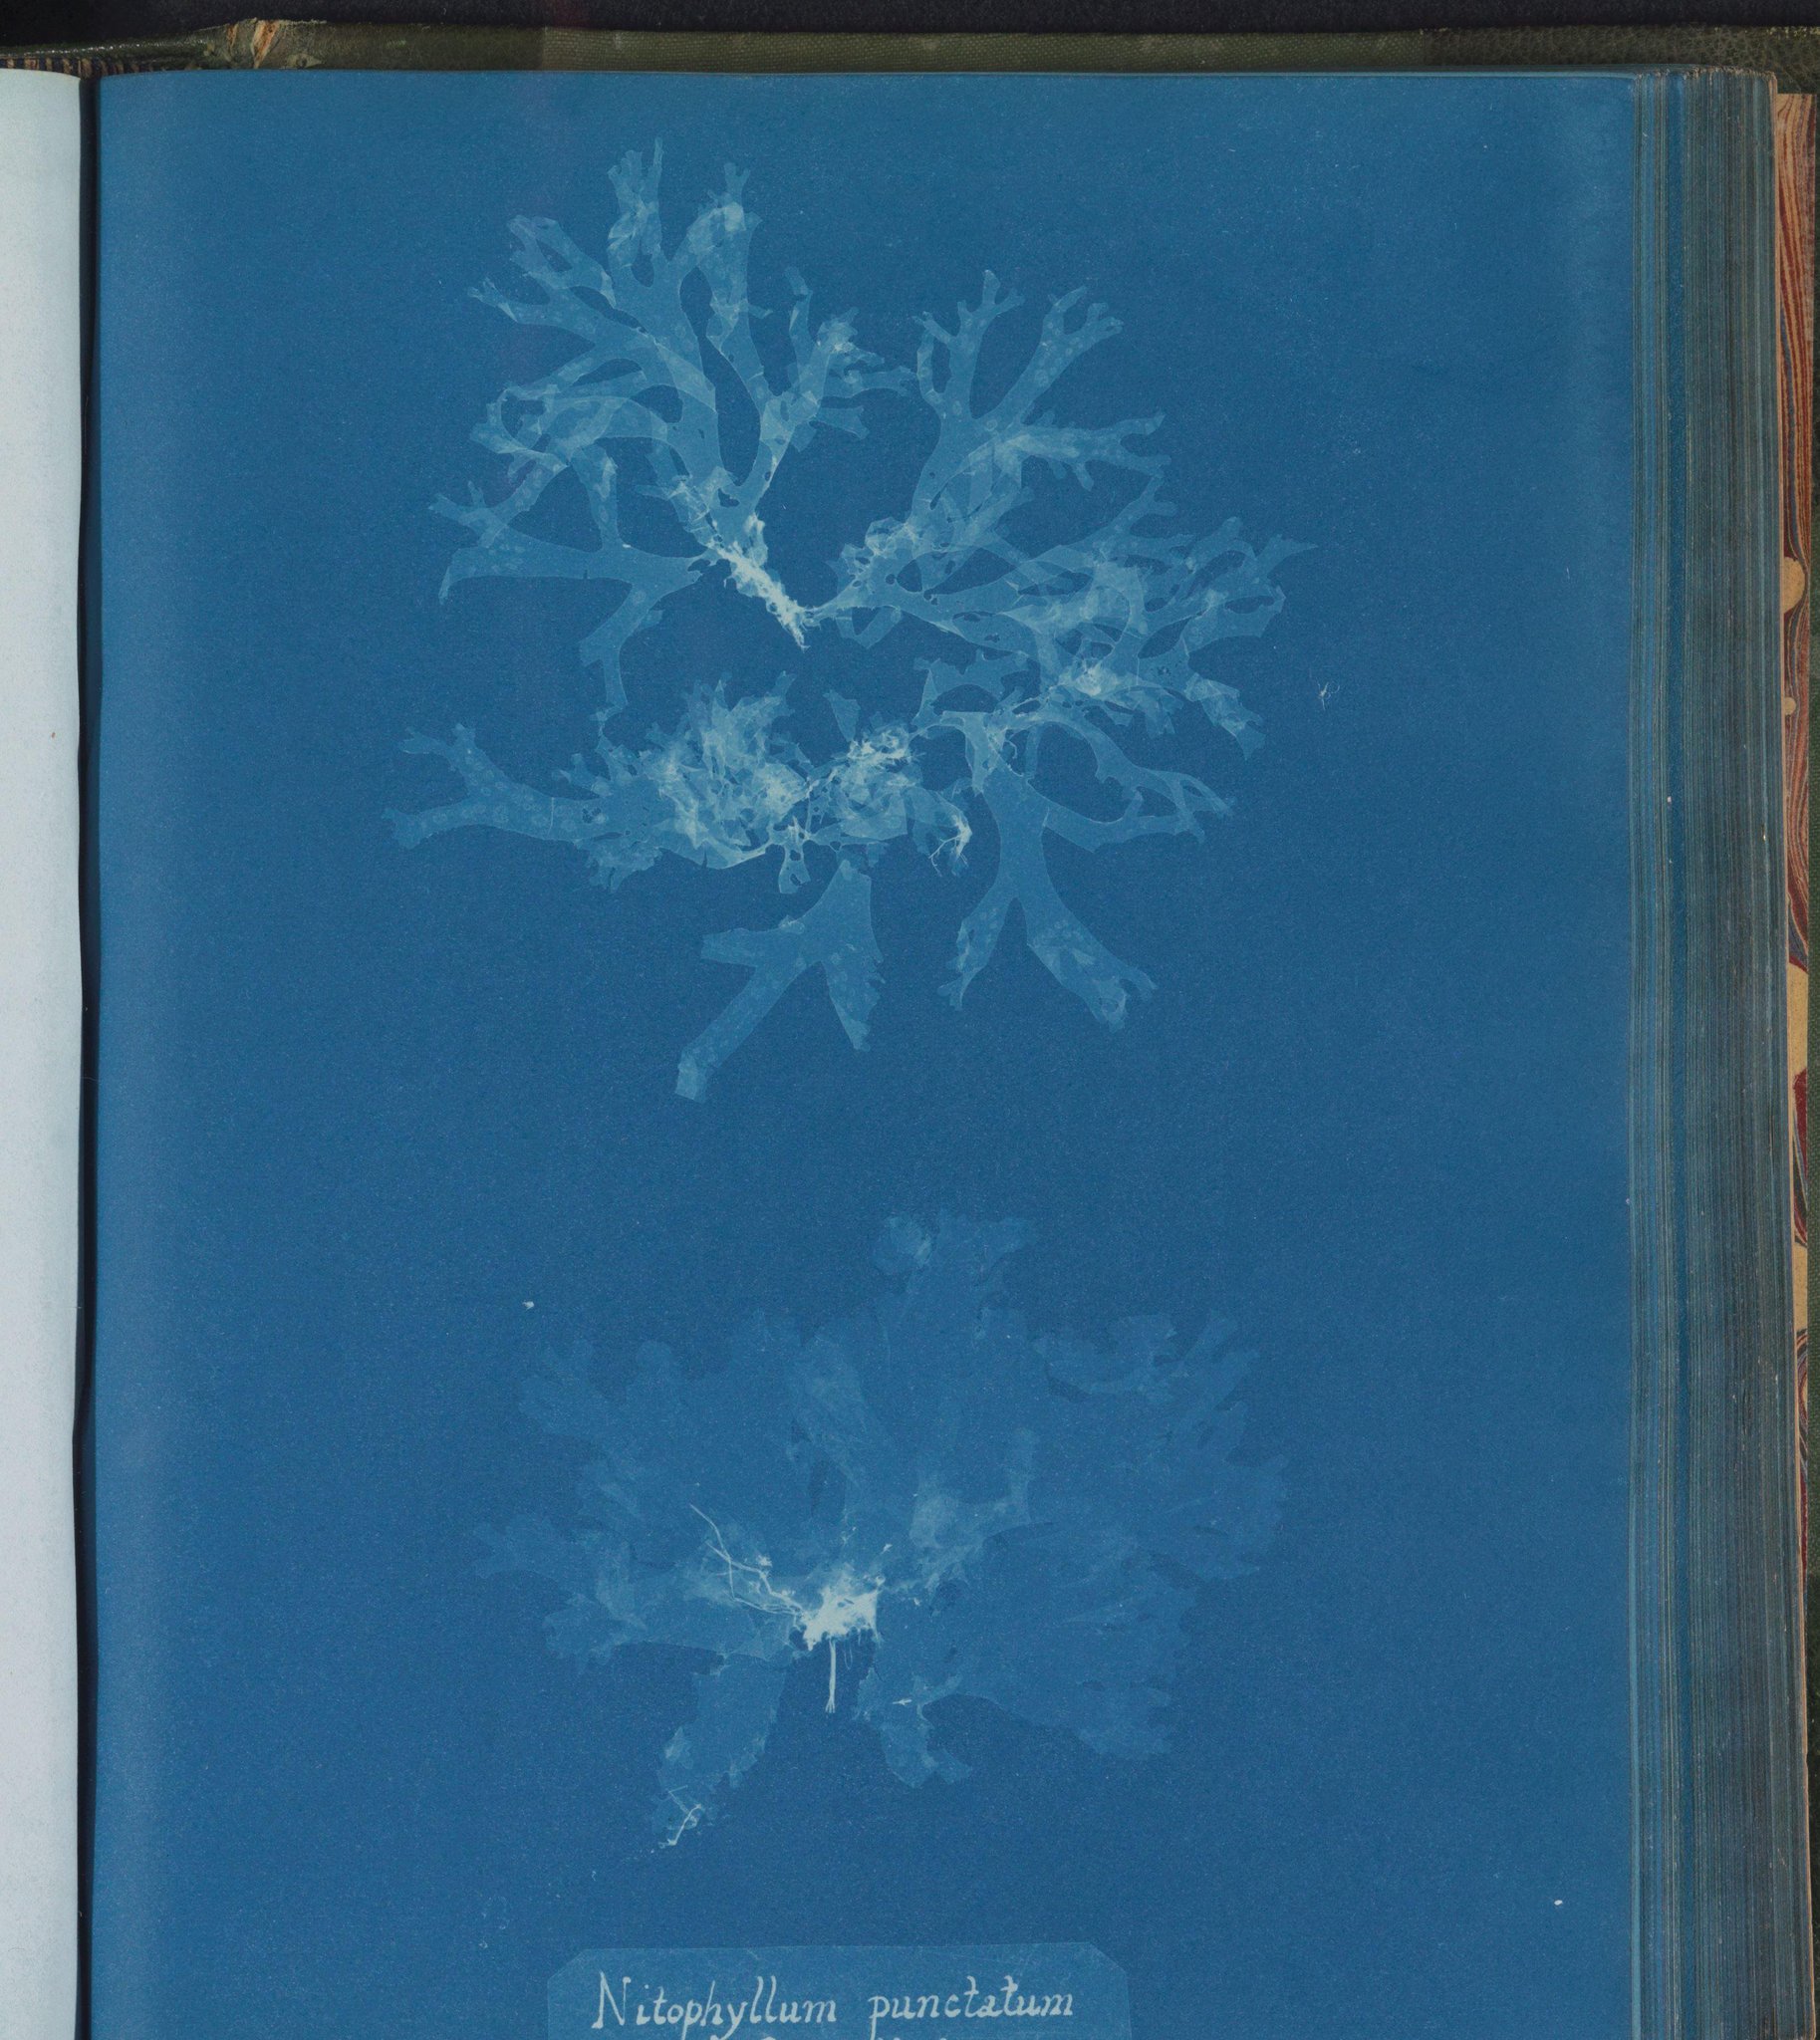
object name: photograph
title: Zeewier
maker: anna atkins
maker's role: fotograaf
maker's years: 1799-1871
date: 1843-1853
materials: photographic support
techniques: cyanotype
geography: united kingdom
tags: algae, seaweed